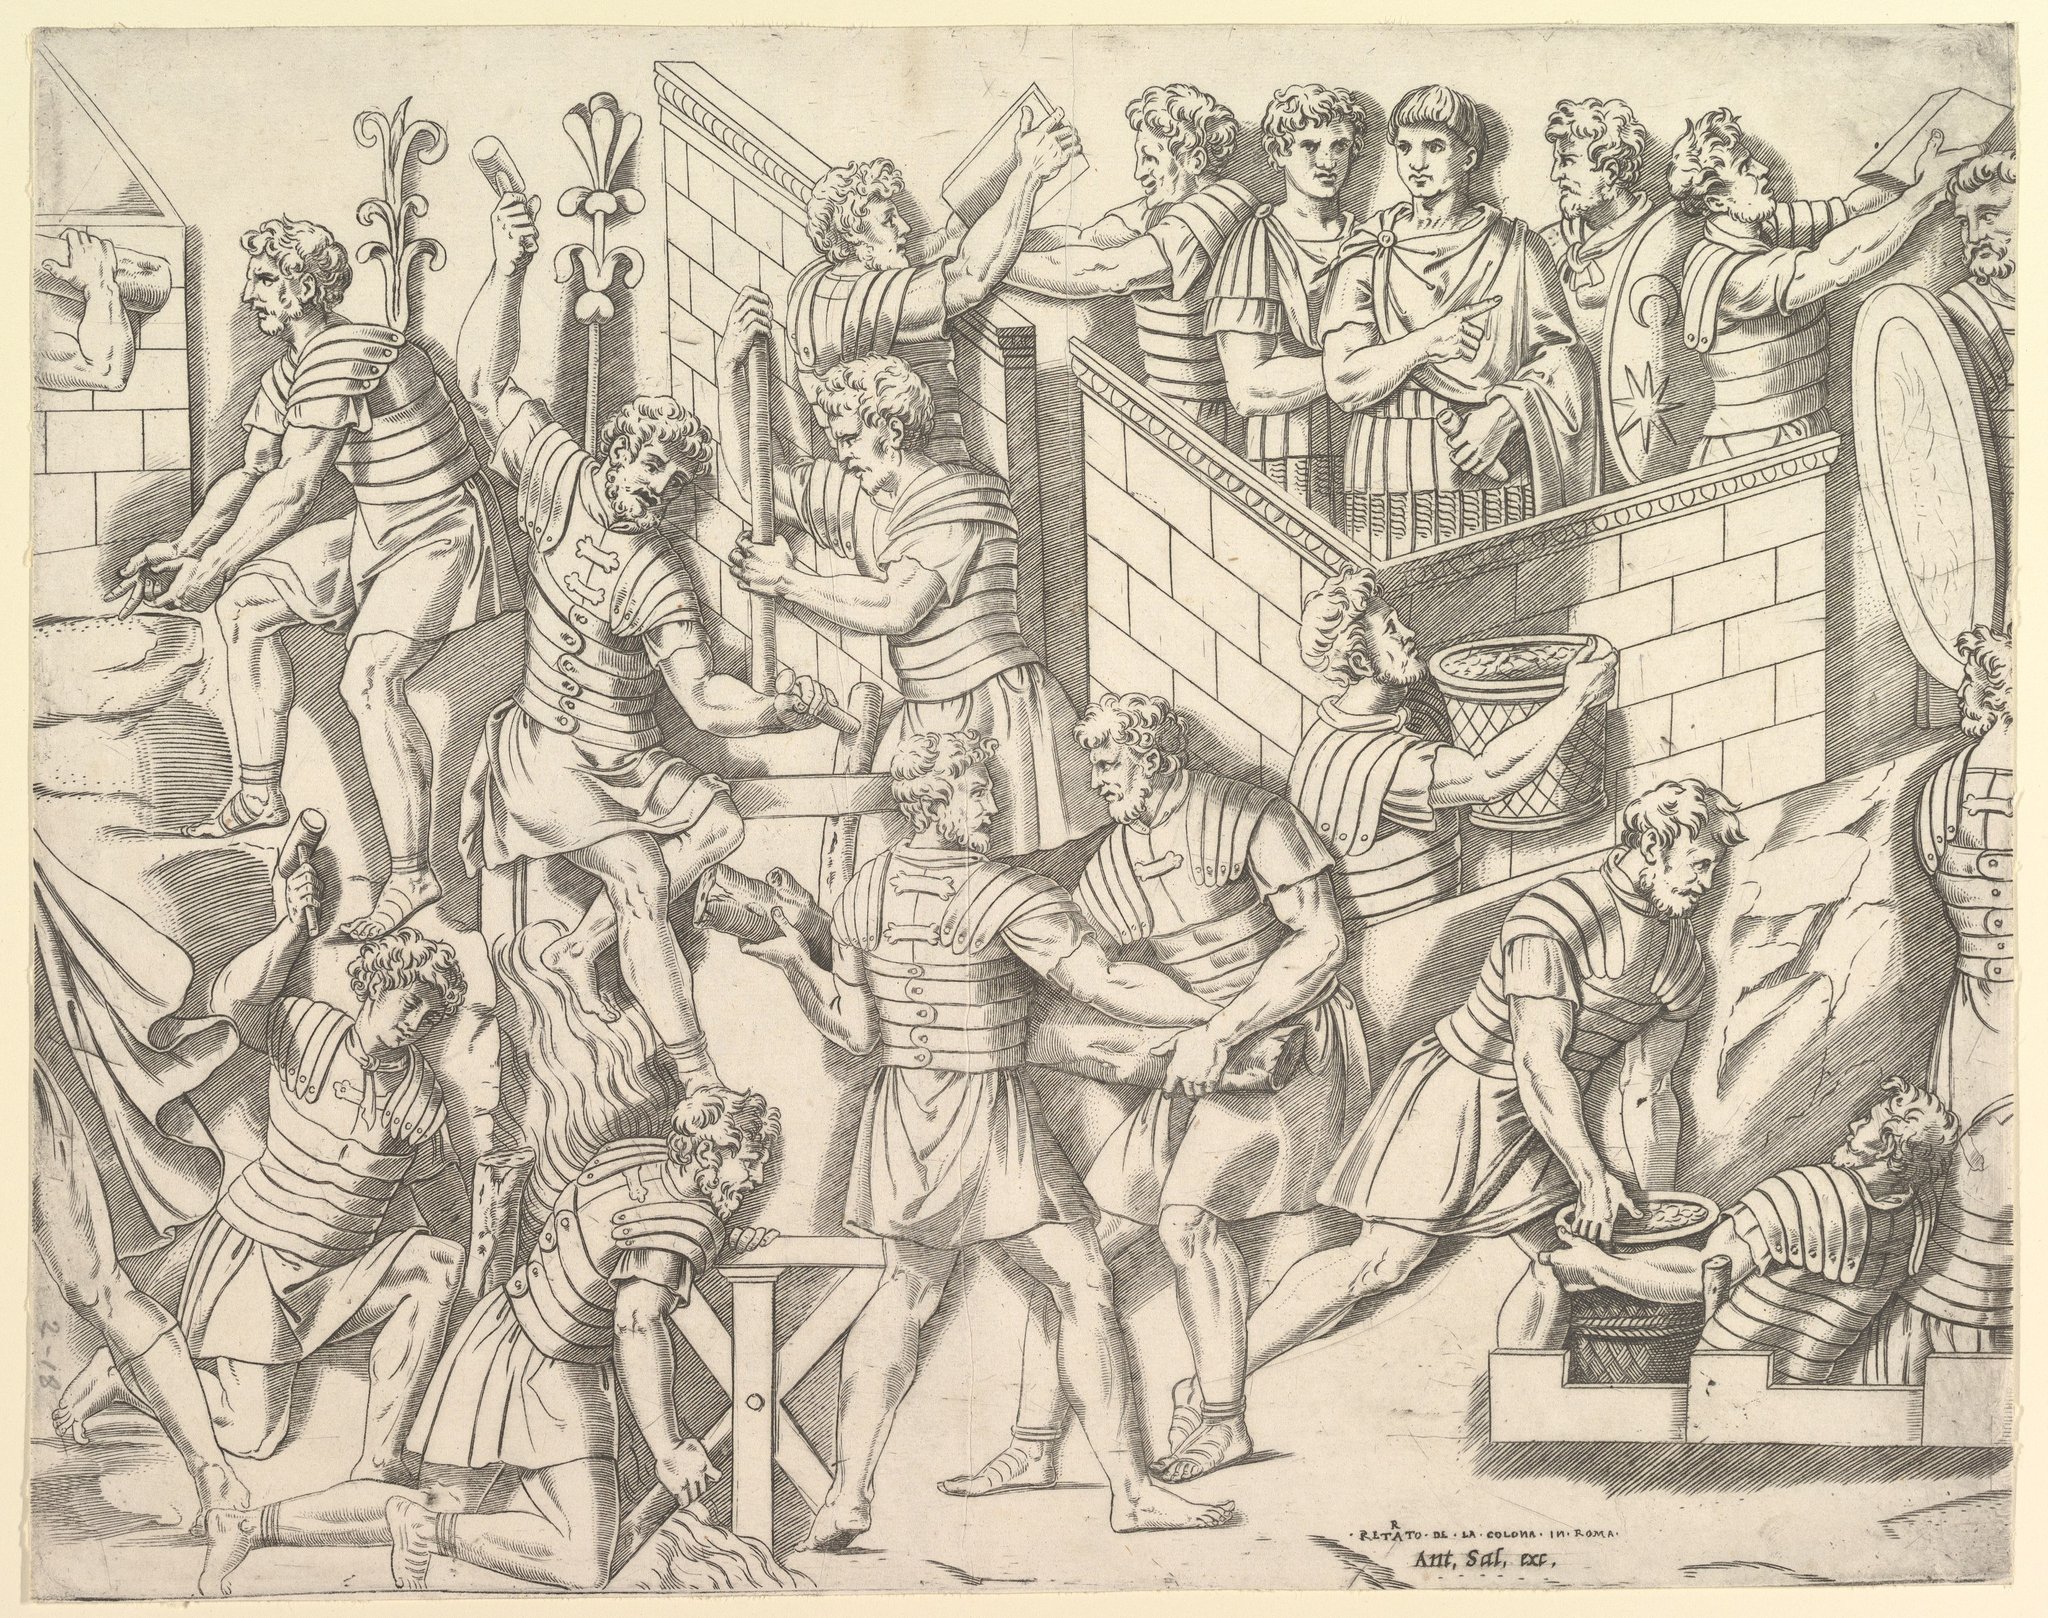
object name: print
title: Roman Soldiers Fortifying their Camp, from Trajan's Column, from "Speculum Romanae Magnificentiae"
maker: marco dente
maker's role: artist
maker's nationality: italian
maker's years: 1515-1527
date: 1501-1600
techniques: engraving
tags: fortification,soldiers,men